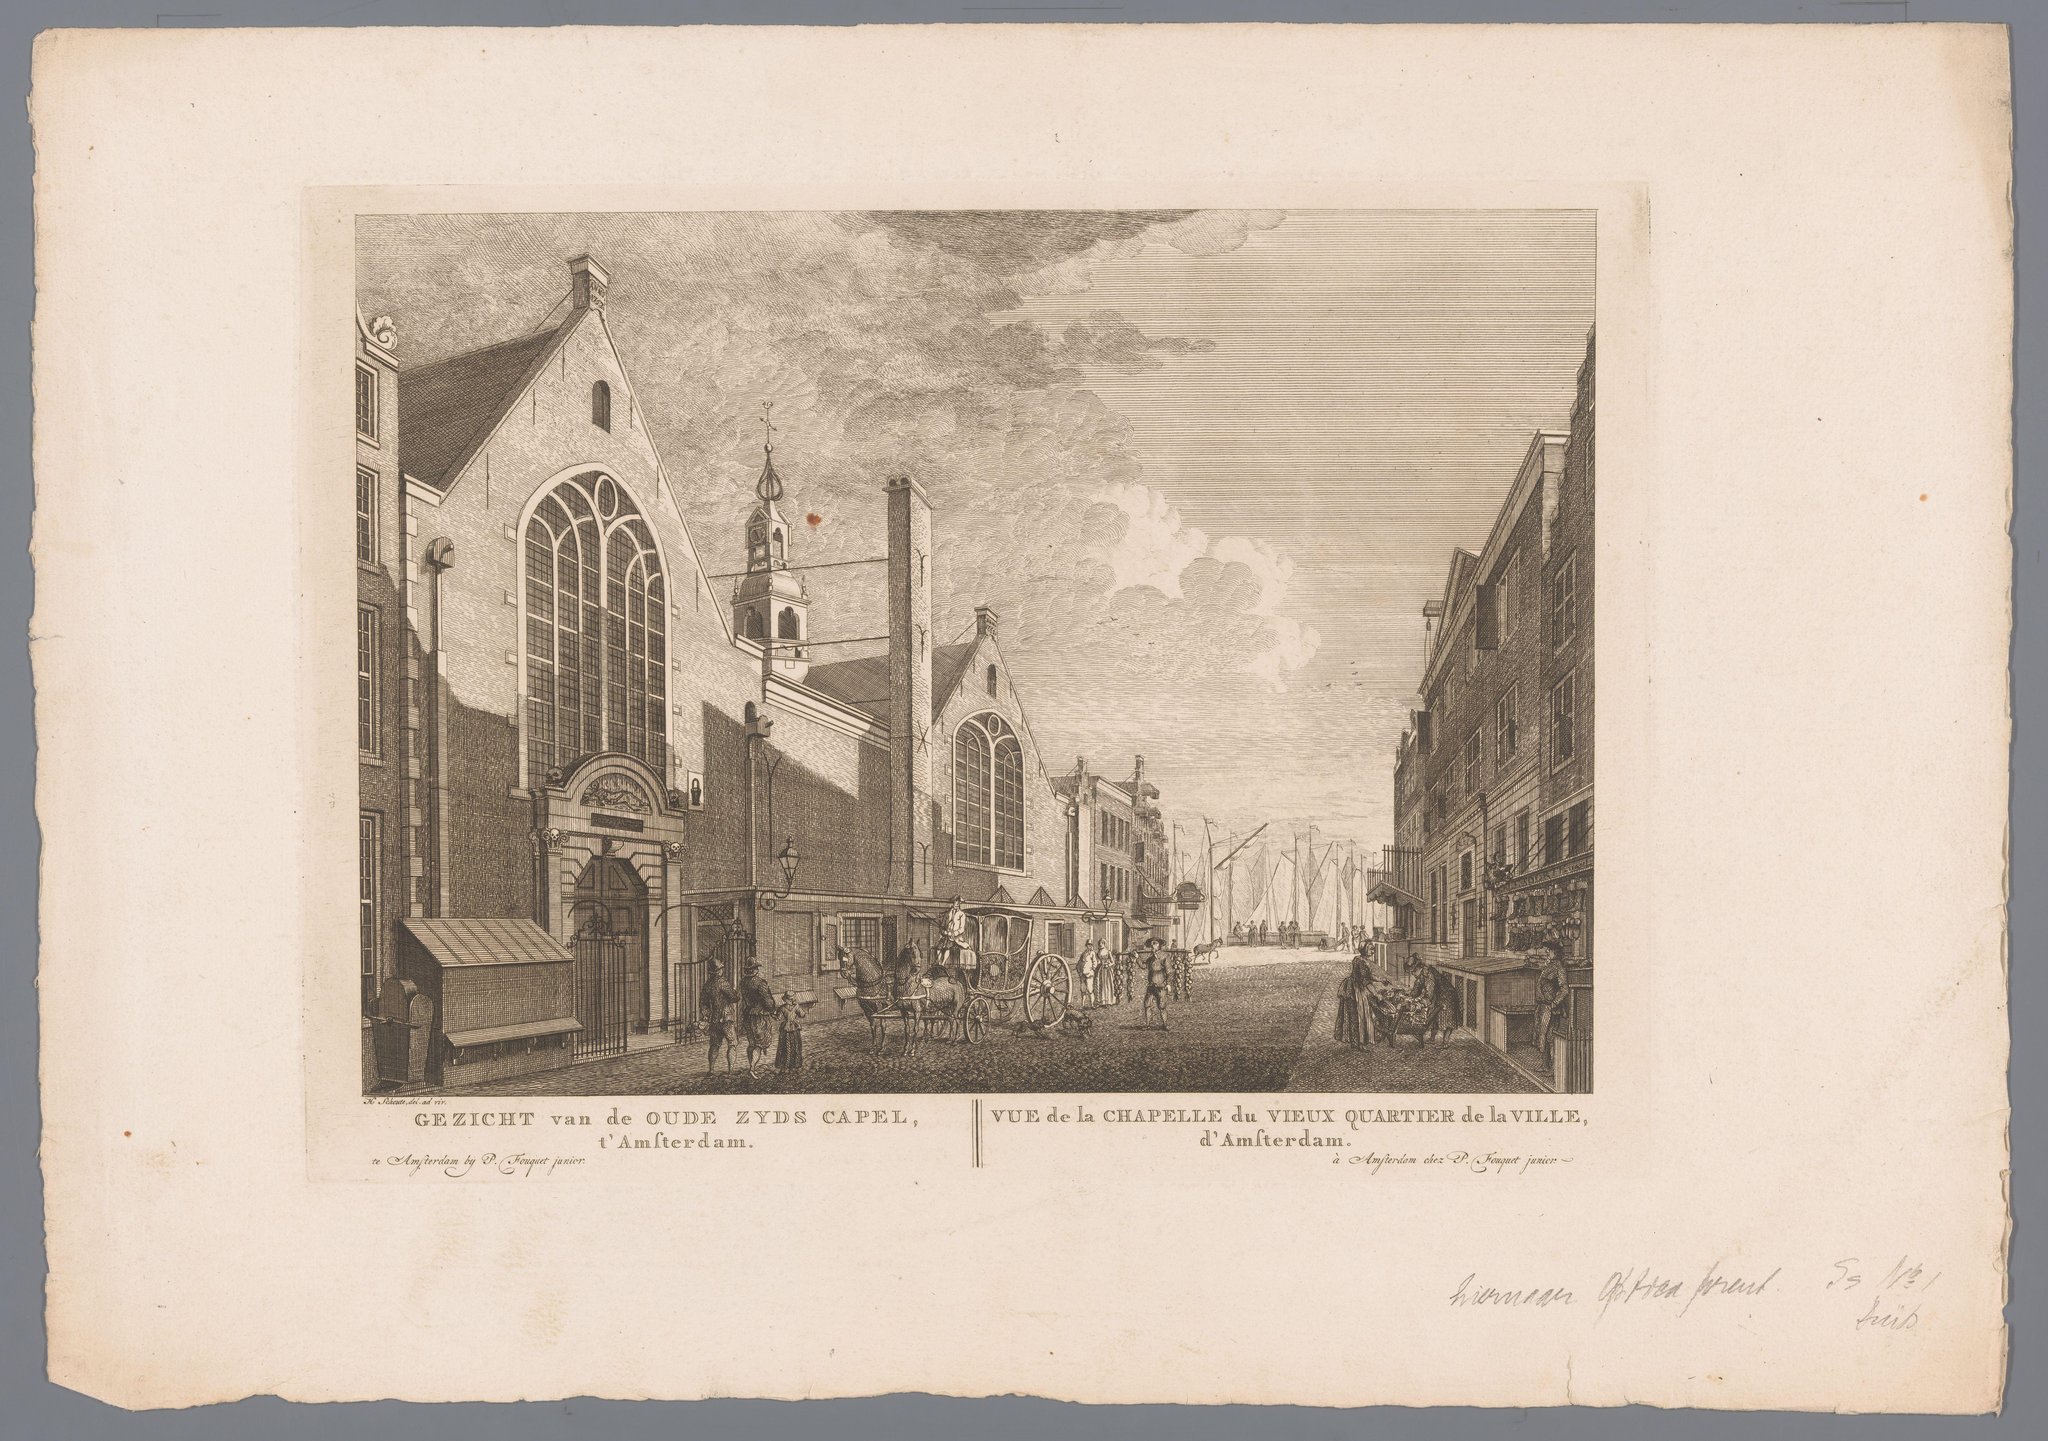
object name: print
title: Gezicht op de Sint-Olofskapel (Oudezijds Kapel) te Amsterdam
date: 1770-1783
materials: paper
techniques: etching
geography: amsterdam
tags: church (exterior) - qq - small church, chapel, street (+ city(-scape) with figures, staffage)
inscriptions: collector's mark: Lugt 2233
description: Vanaf 1760 gaf Pierre Fouquet stadsgezichten van Amsterdam naar tekeningen van verschillende kunstenaars uit. Deze prenten werden aanvankelijk los verkocht. Later werden ze samengebonden verkocht in verschillende volgordes en aantallen in: (1). Afbeeldingen van de wyd-vermaarde koopstad Amsterdam benevens des zelvs voornaamste gebouwen en gezigten alle naar het leeven getekend / Receuil des edifices les plus considerables et des plus belles vues, de la fameuse ville d'Amsterdam, dessinées d'après nature. Amsterdam: Pierre Fouquet, 1778-1783. Deze 'uitgave' bestond waarschijnlijk alleen uit een titelblad en inhoudsopgave van de tot dusver 100 uitgegeven prenten, die de koper zelf aan zijn of haar reeds verzamelde prenten kon toevoegen. De hoeveelheid en volgorde van prenten verzameld onder deze titel verschilt dus sterk. (2). Nieuwe atlas, van de voornaamste gebouwen en gezigten der stad Amsterdam, met derzelver beknopte beschryvingen. 2 dln. Amsterdam: Daniël Jean Changuion en Petrus den Hengst [in opdracht van Pierre Fouquet], 1783. Ook werden er door verschillende uitgevers tussen 1788 (Amsterdam: Petrus Conradi) en 1805 (Amsterdam: Evert Maaskamp) heruitgaven gepubliceerd.